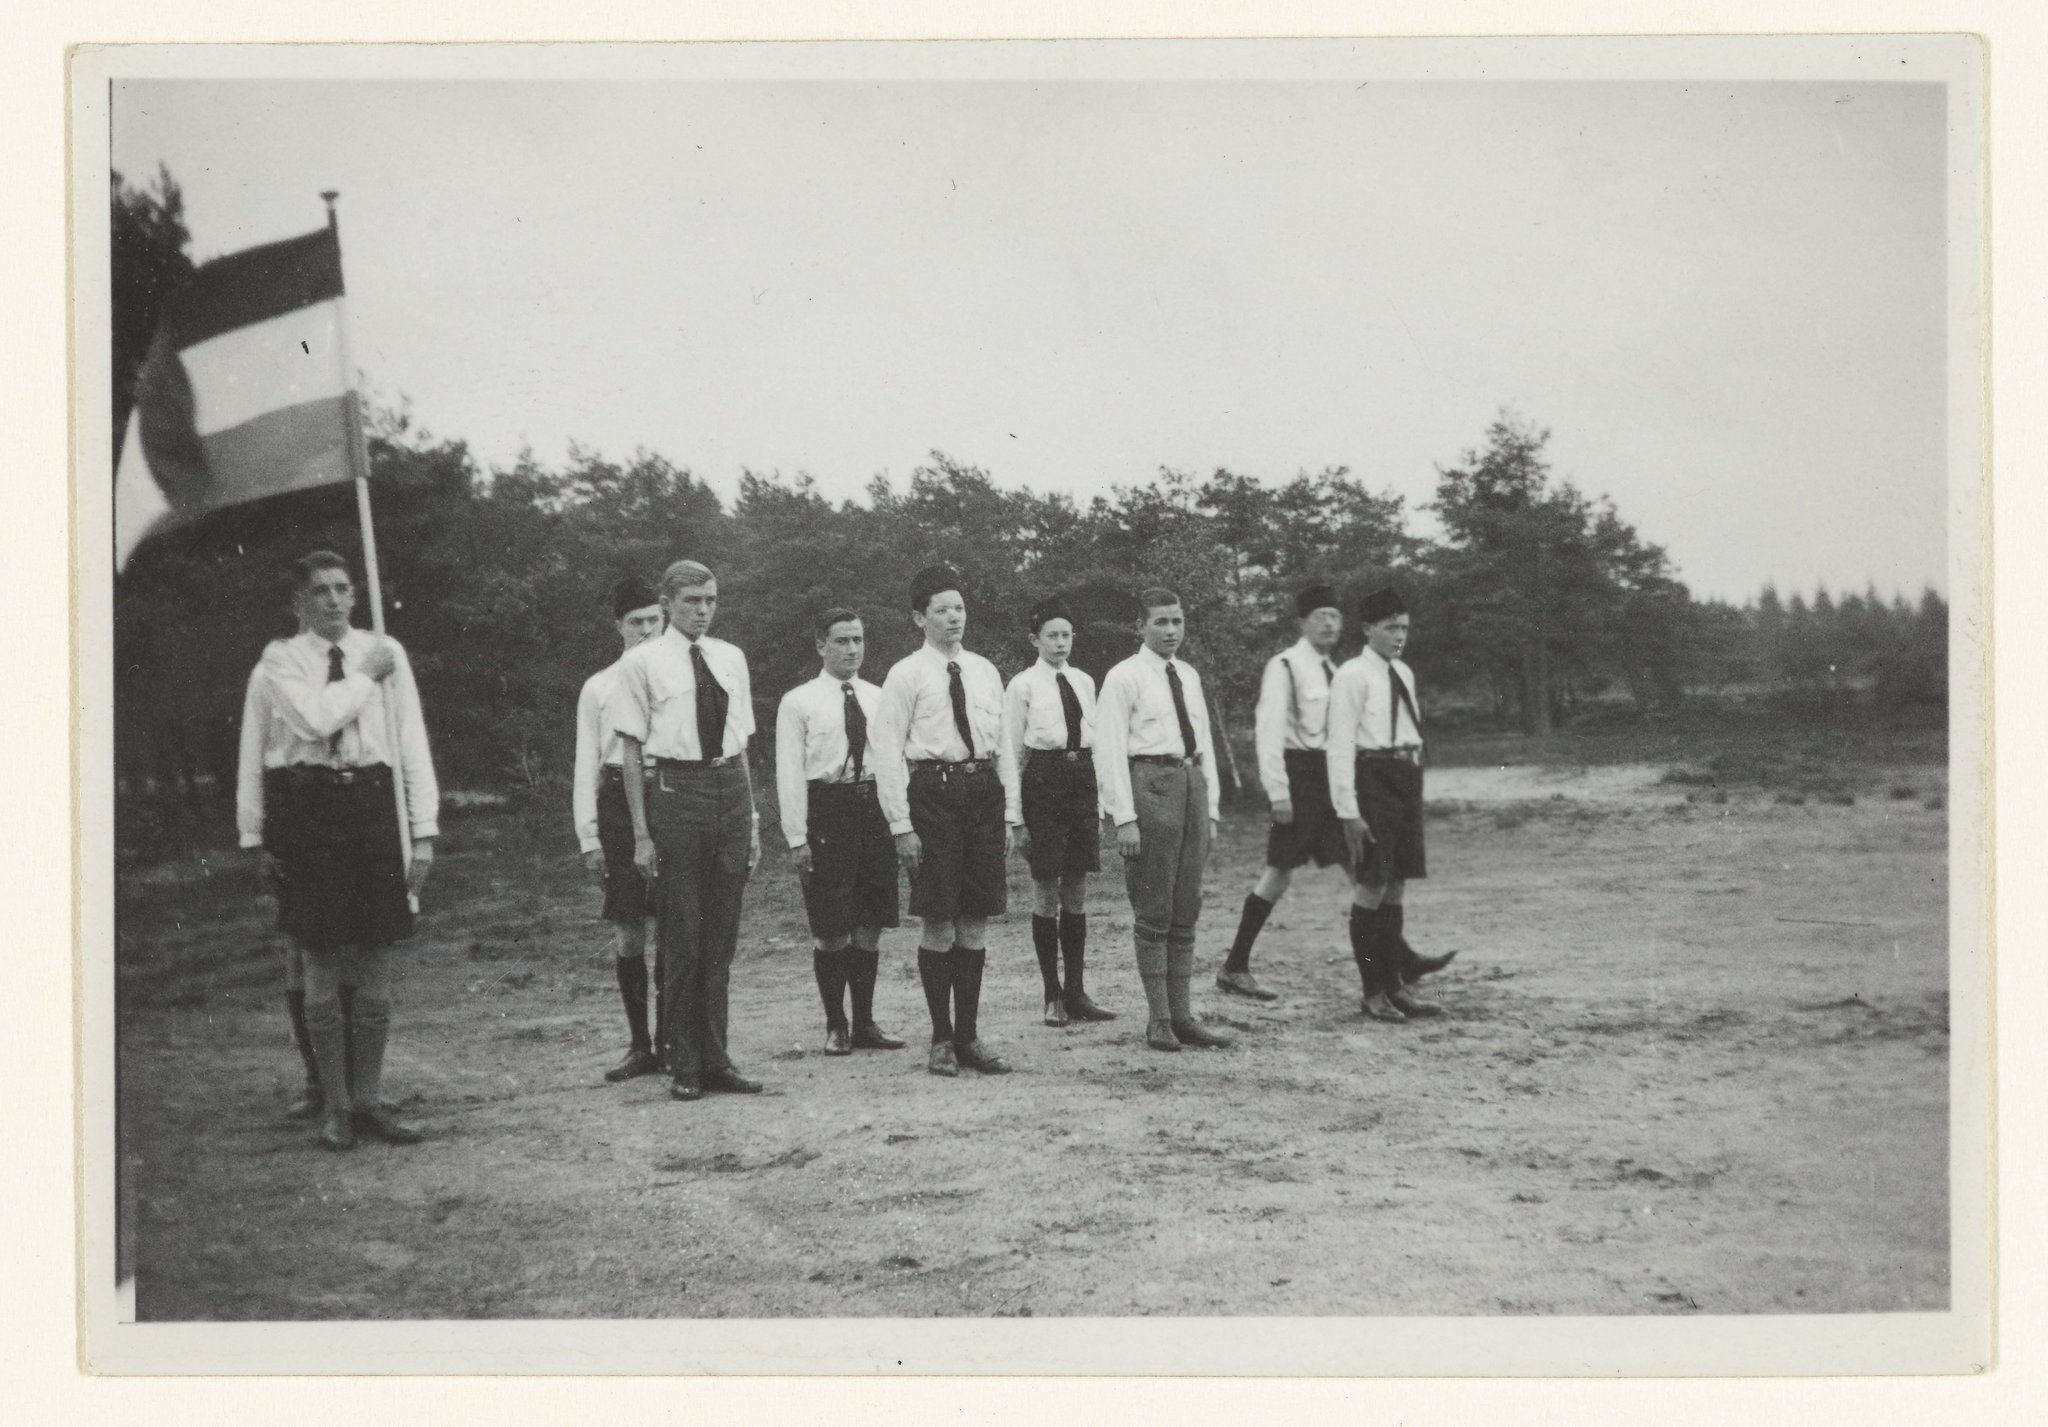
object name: photograph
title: Jongens van de Jeugdstorm met de Nederlandse vlag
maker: Anonymous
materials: photographic support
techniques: photography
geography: bilthoven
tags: military instruction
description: Jongens van de Jeugdstorm tijdens of na het afleggen van de gelofte op de Jeugdstorm tijdens hun installatie als lid. Links een lid met de Nederlandse vlag. Op achterzijde foto: Installatie van troep I. ( Gelofte ). De foto maakt deel uit van een serie van circa 35 amateurfoto's.